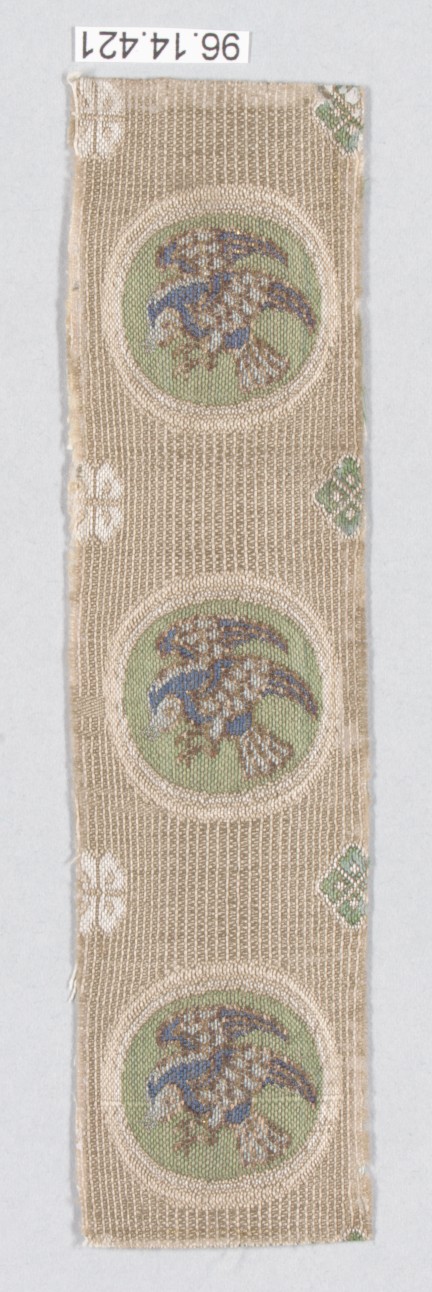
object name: piece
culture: japanese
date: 1701-1900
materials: silk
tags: birds